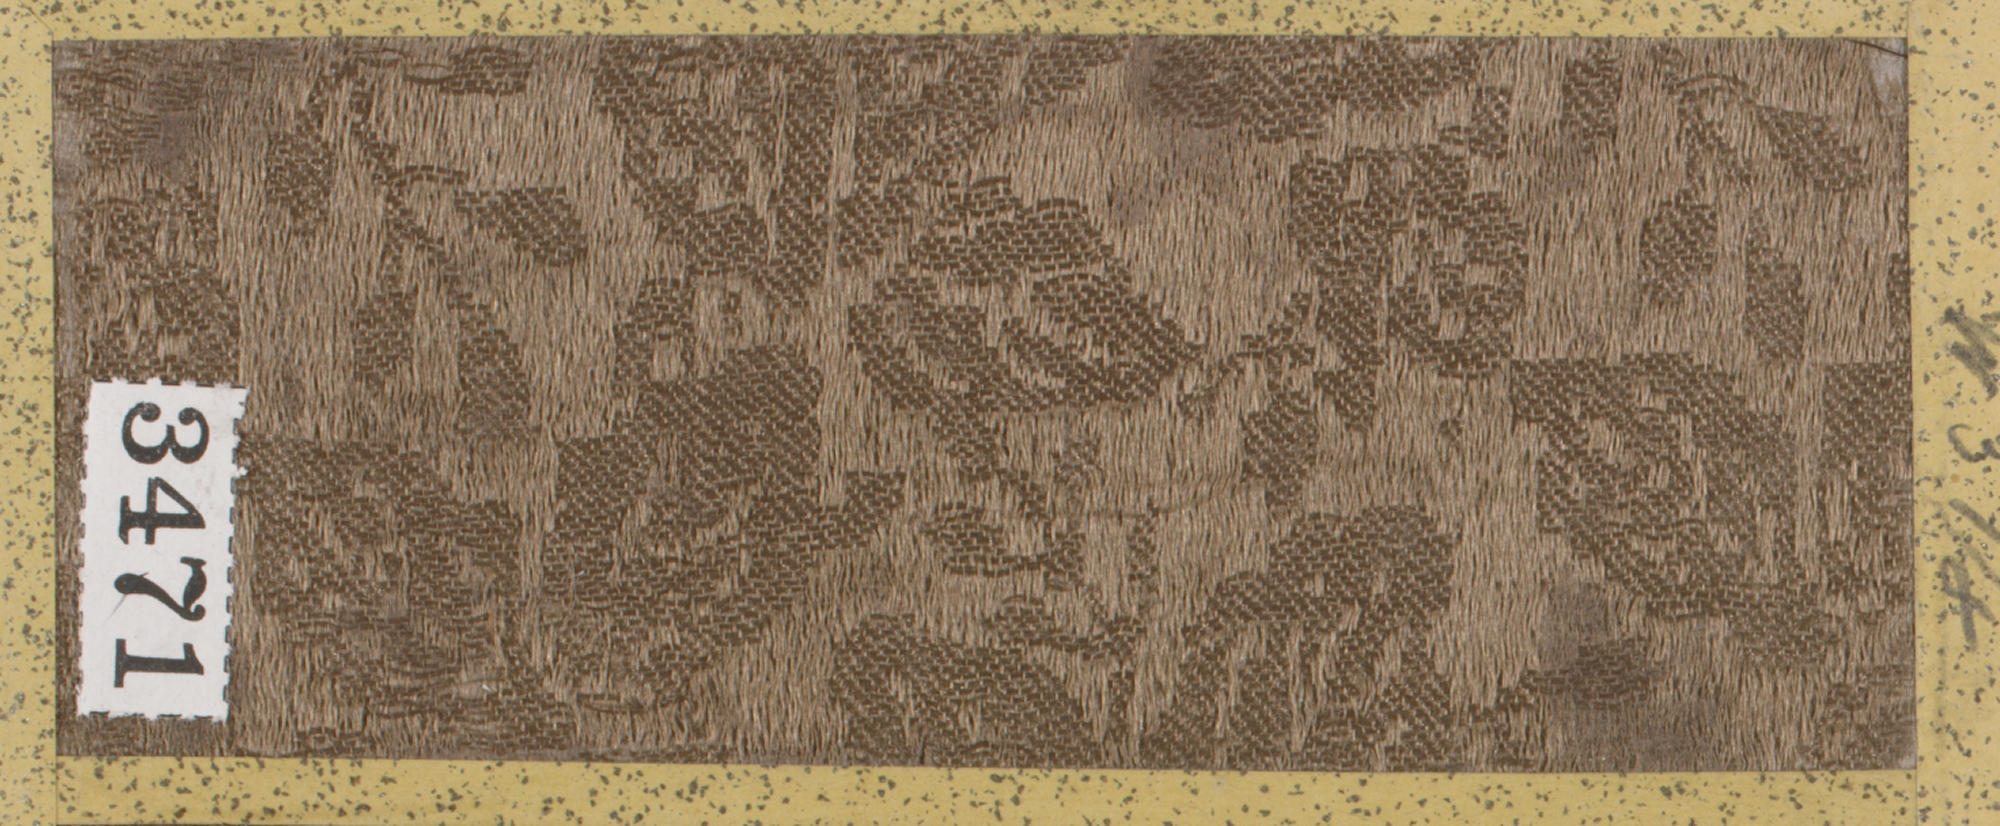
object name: sample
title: Textile Sample from Sample Book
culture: japanese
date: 1801-1900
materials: silk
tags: leaves